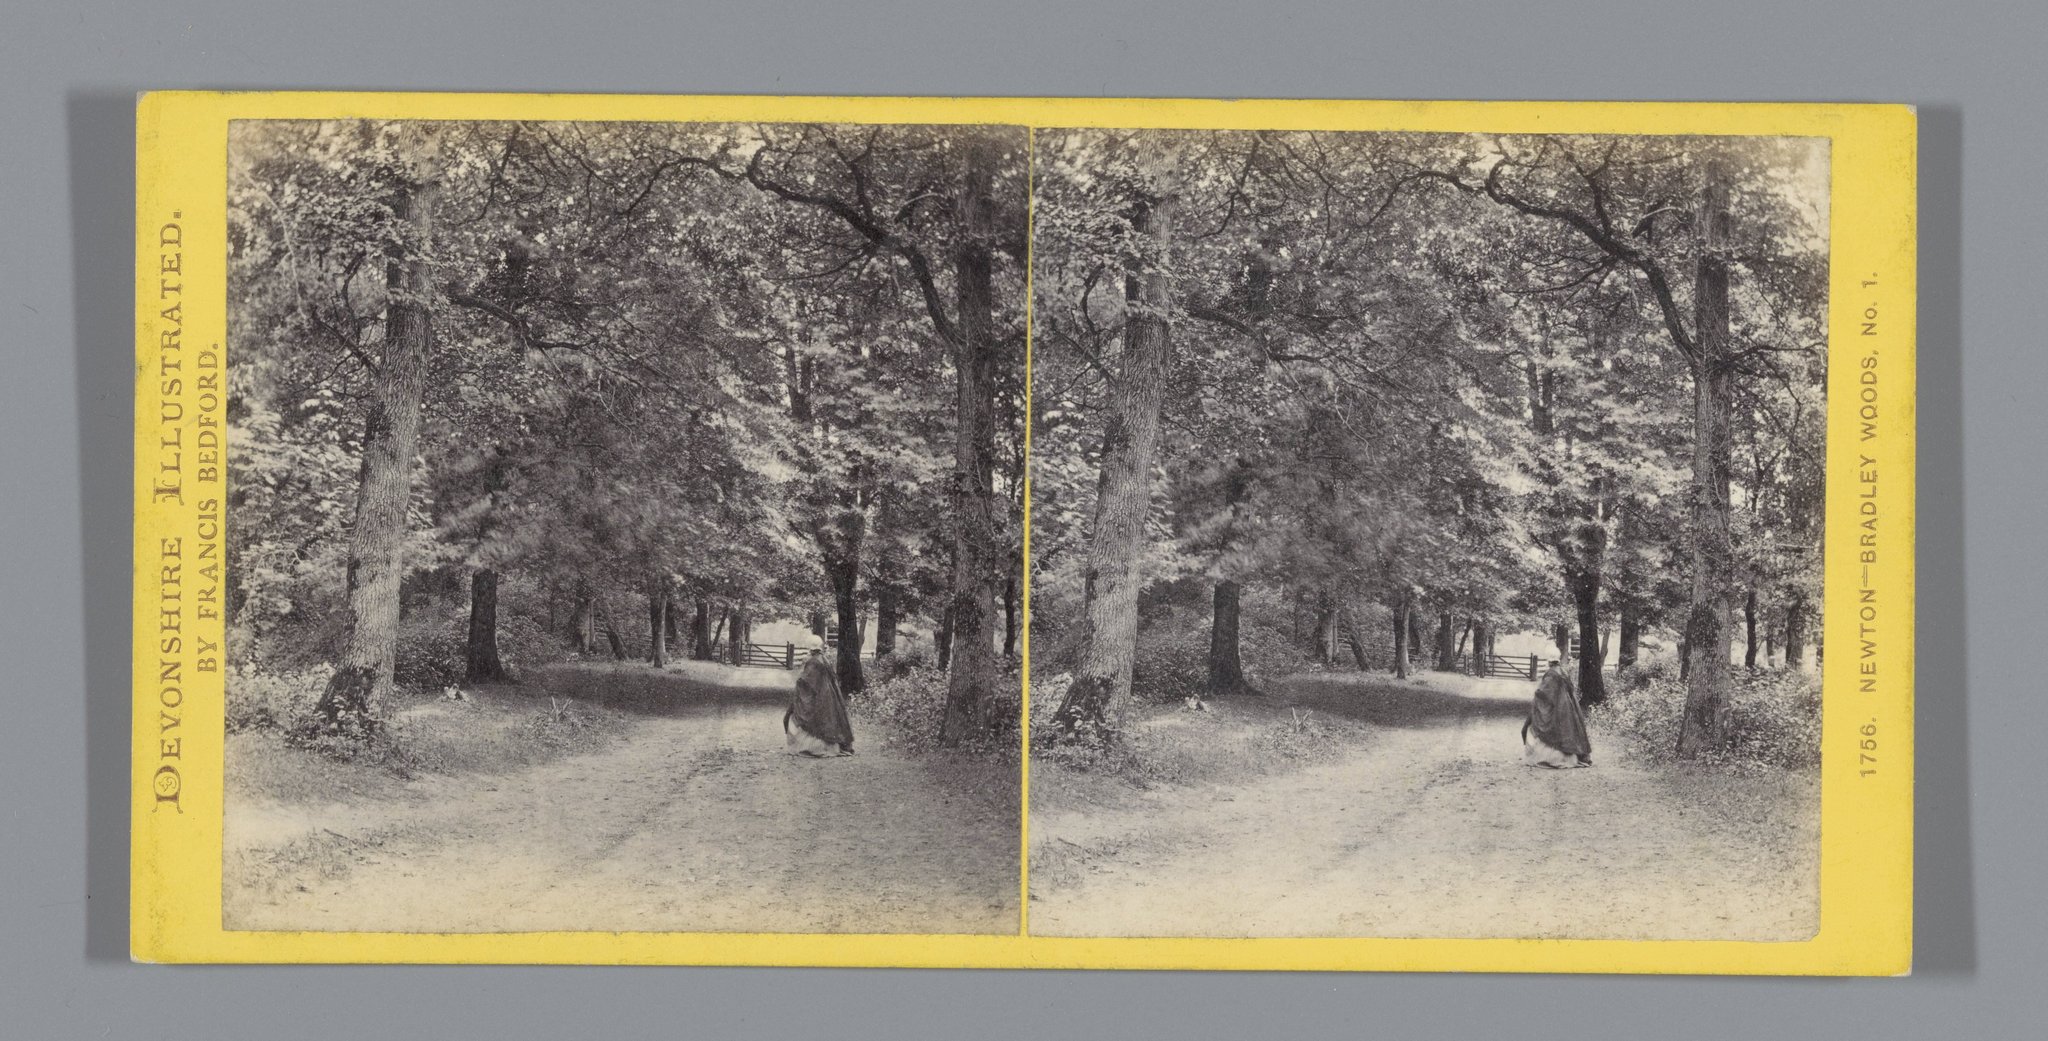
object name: stereograph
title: Pad in de Bradley Woods bij Newton Abbot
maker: francis bedford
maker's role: print maker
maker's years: 1815-1894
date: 1850-1880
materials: cardboard, photographic support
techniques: albumen print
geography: devon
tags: forest, wood, forest path or lane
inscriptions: number: ‘1756.’, inscription: ‘Devonshire Illustrated. by Francis Bedford.’